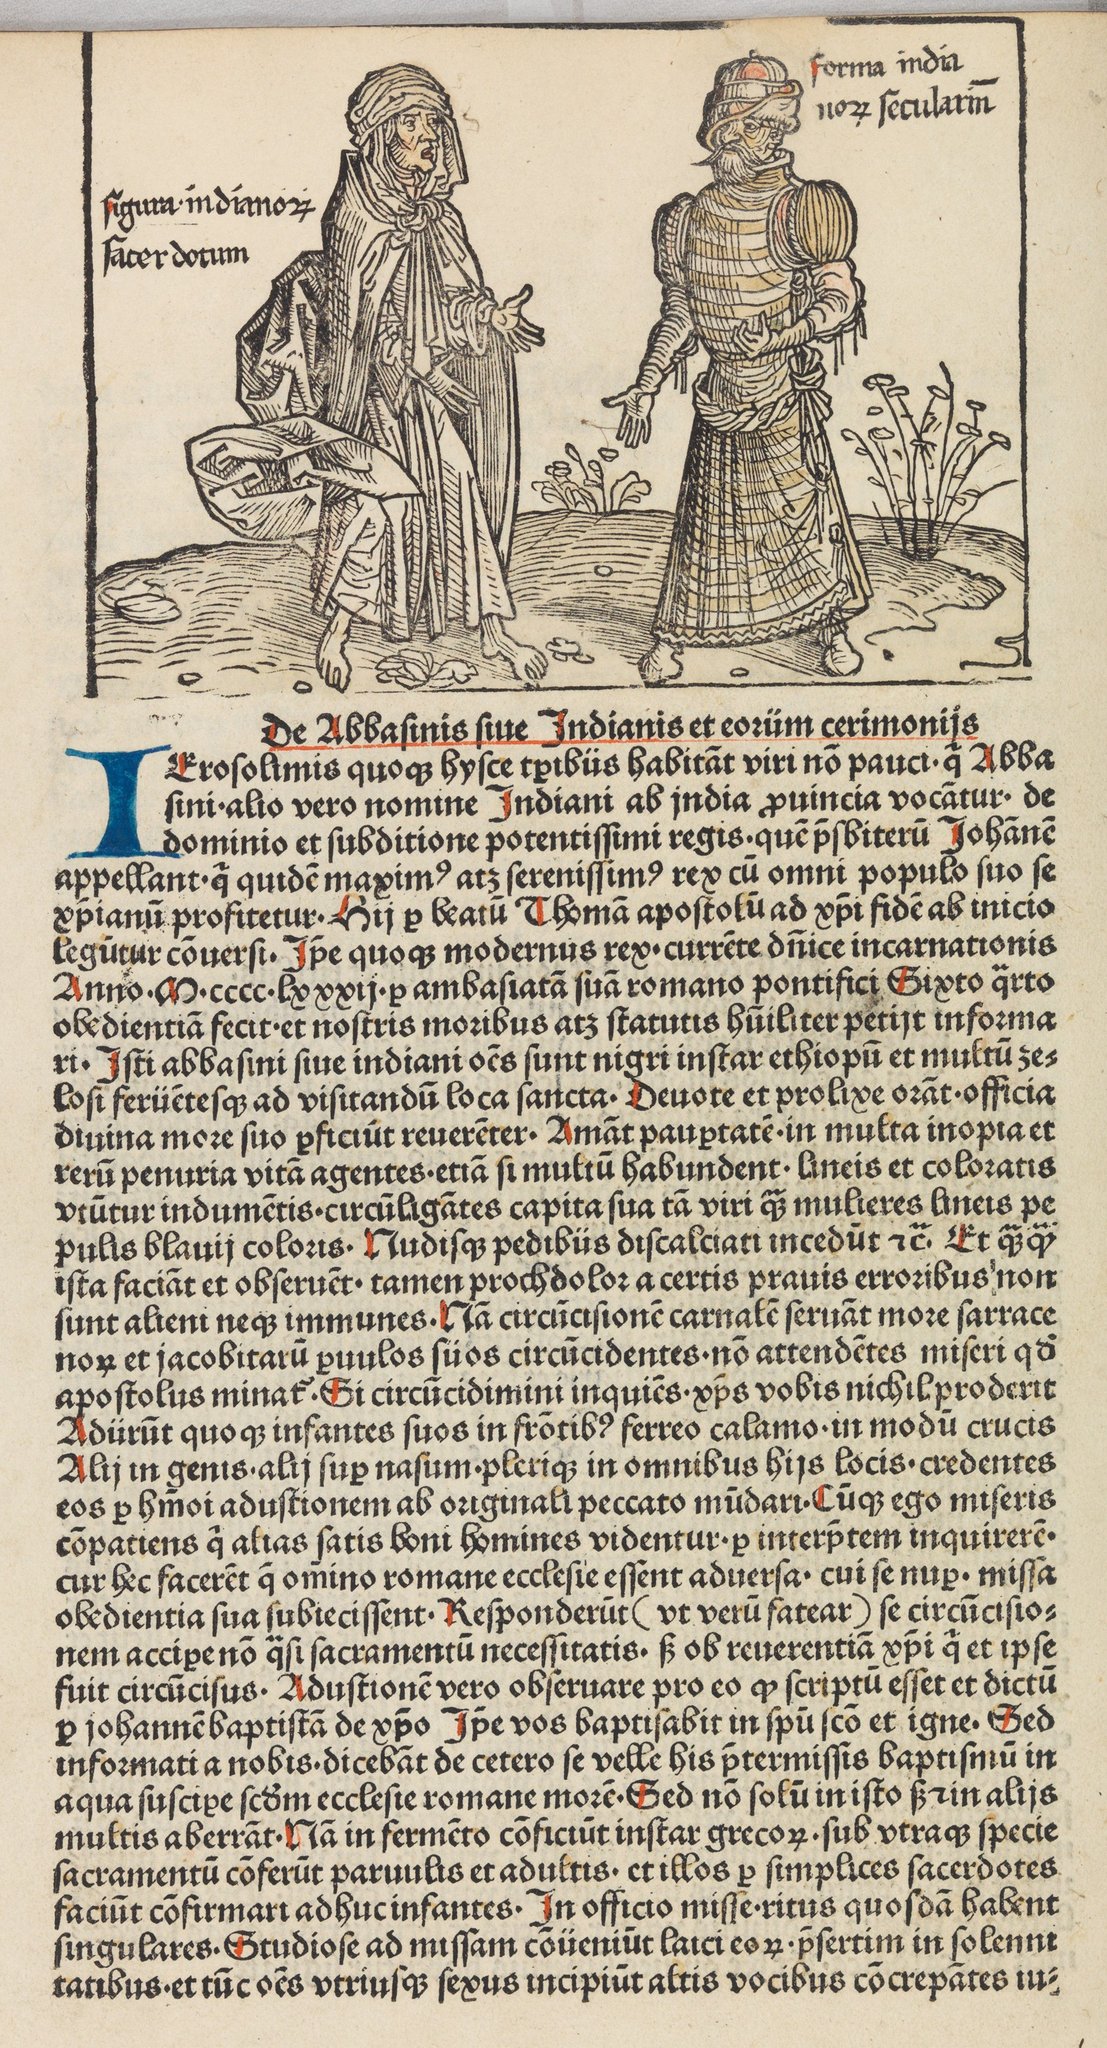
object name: book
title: Peregrinatio in terram sanctam.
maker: bernhard von breydenbach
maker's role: author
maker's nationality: german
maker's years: 1440-1497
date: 1486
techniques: woodcut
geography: germany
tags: men,trees